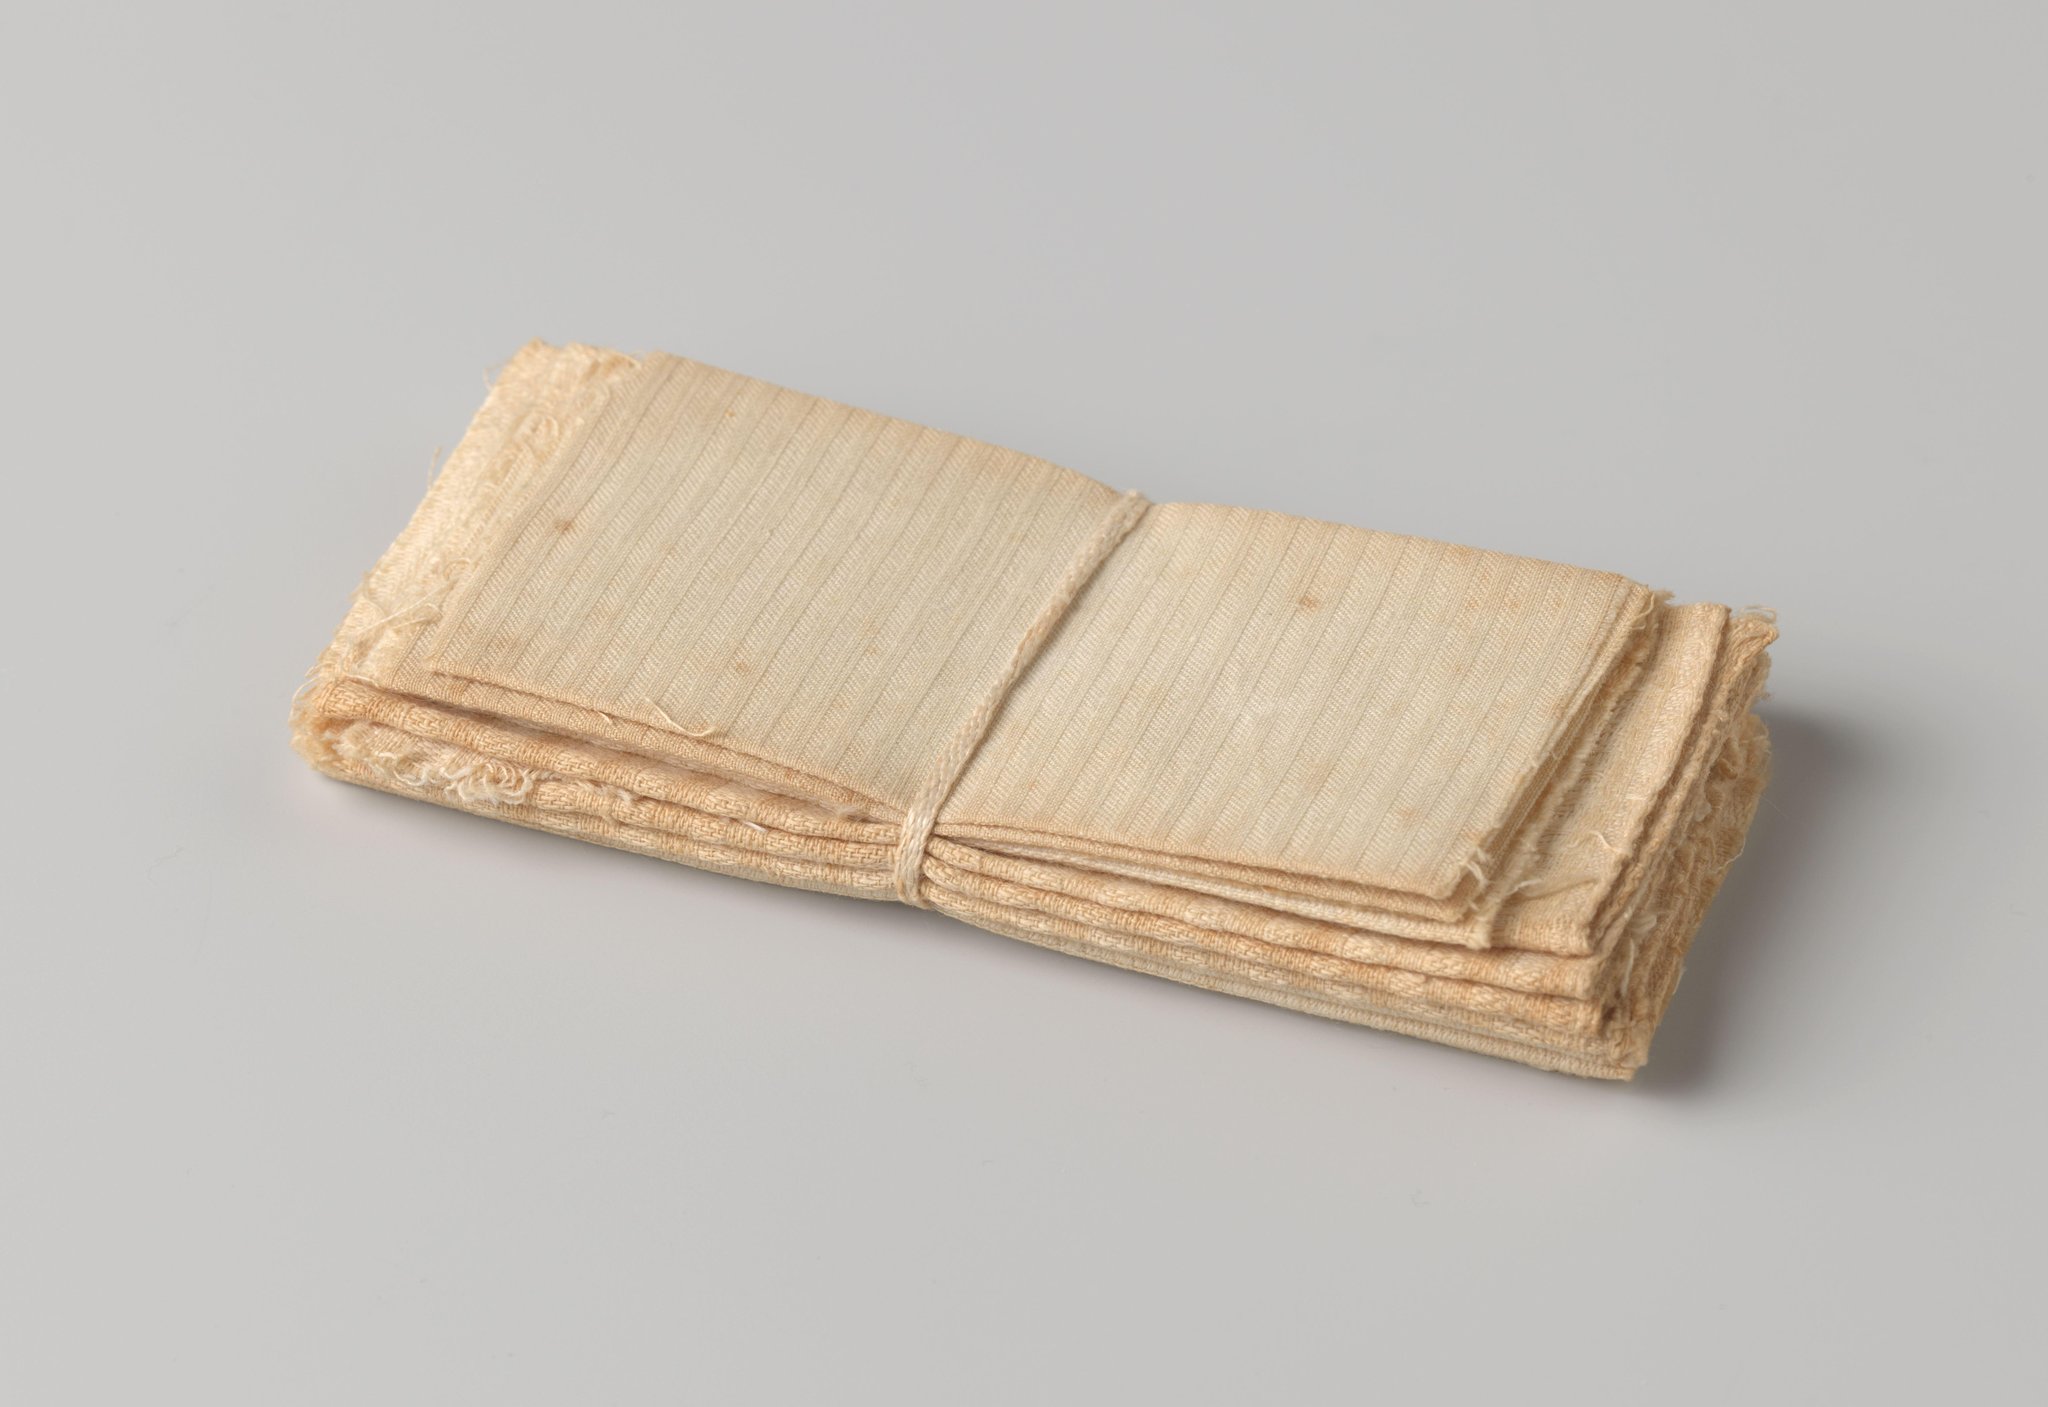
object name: lap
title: Stapel van tien lappen, samengebonden met band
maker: Anonymous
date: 1750-1800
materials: cotton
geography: netherlands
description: Een stapel van tien opgevouwen en met katoenen band samengebonden lappen van katoen met streepmotief van verschillende breedtes (twee met smalle en acht met brede strepen).